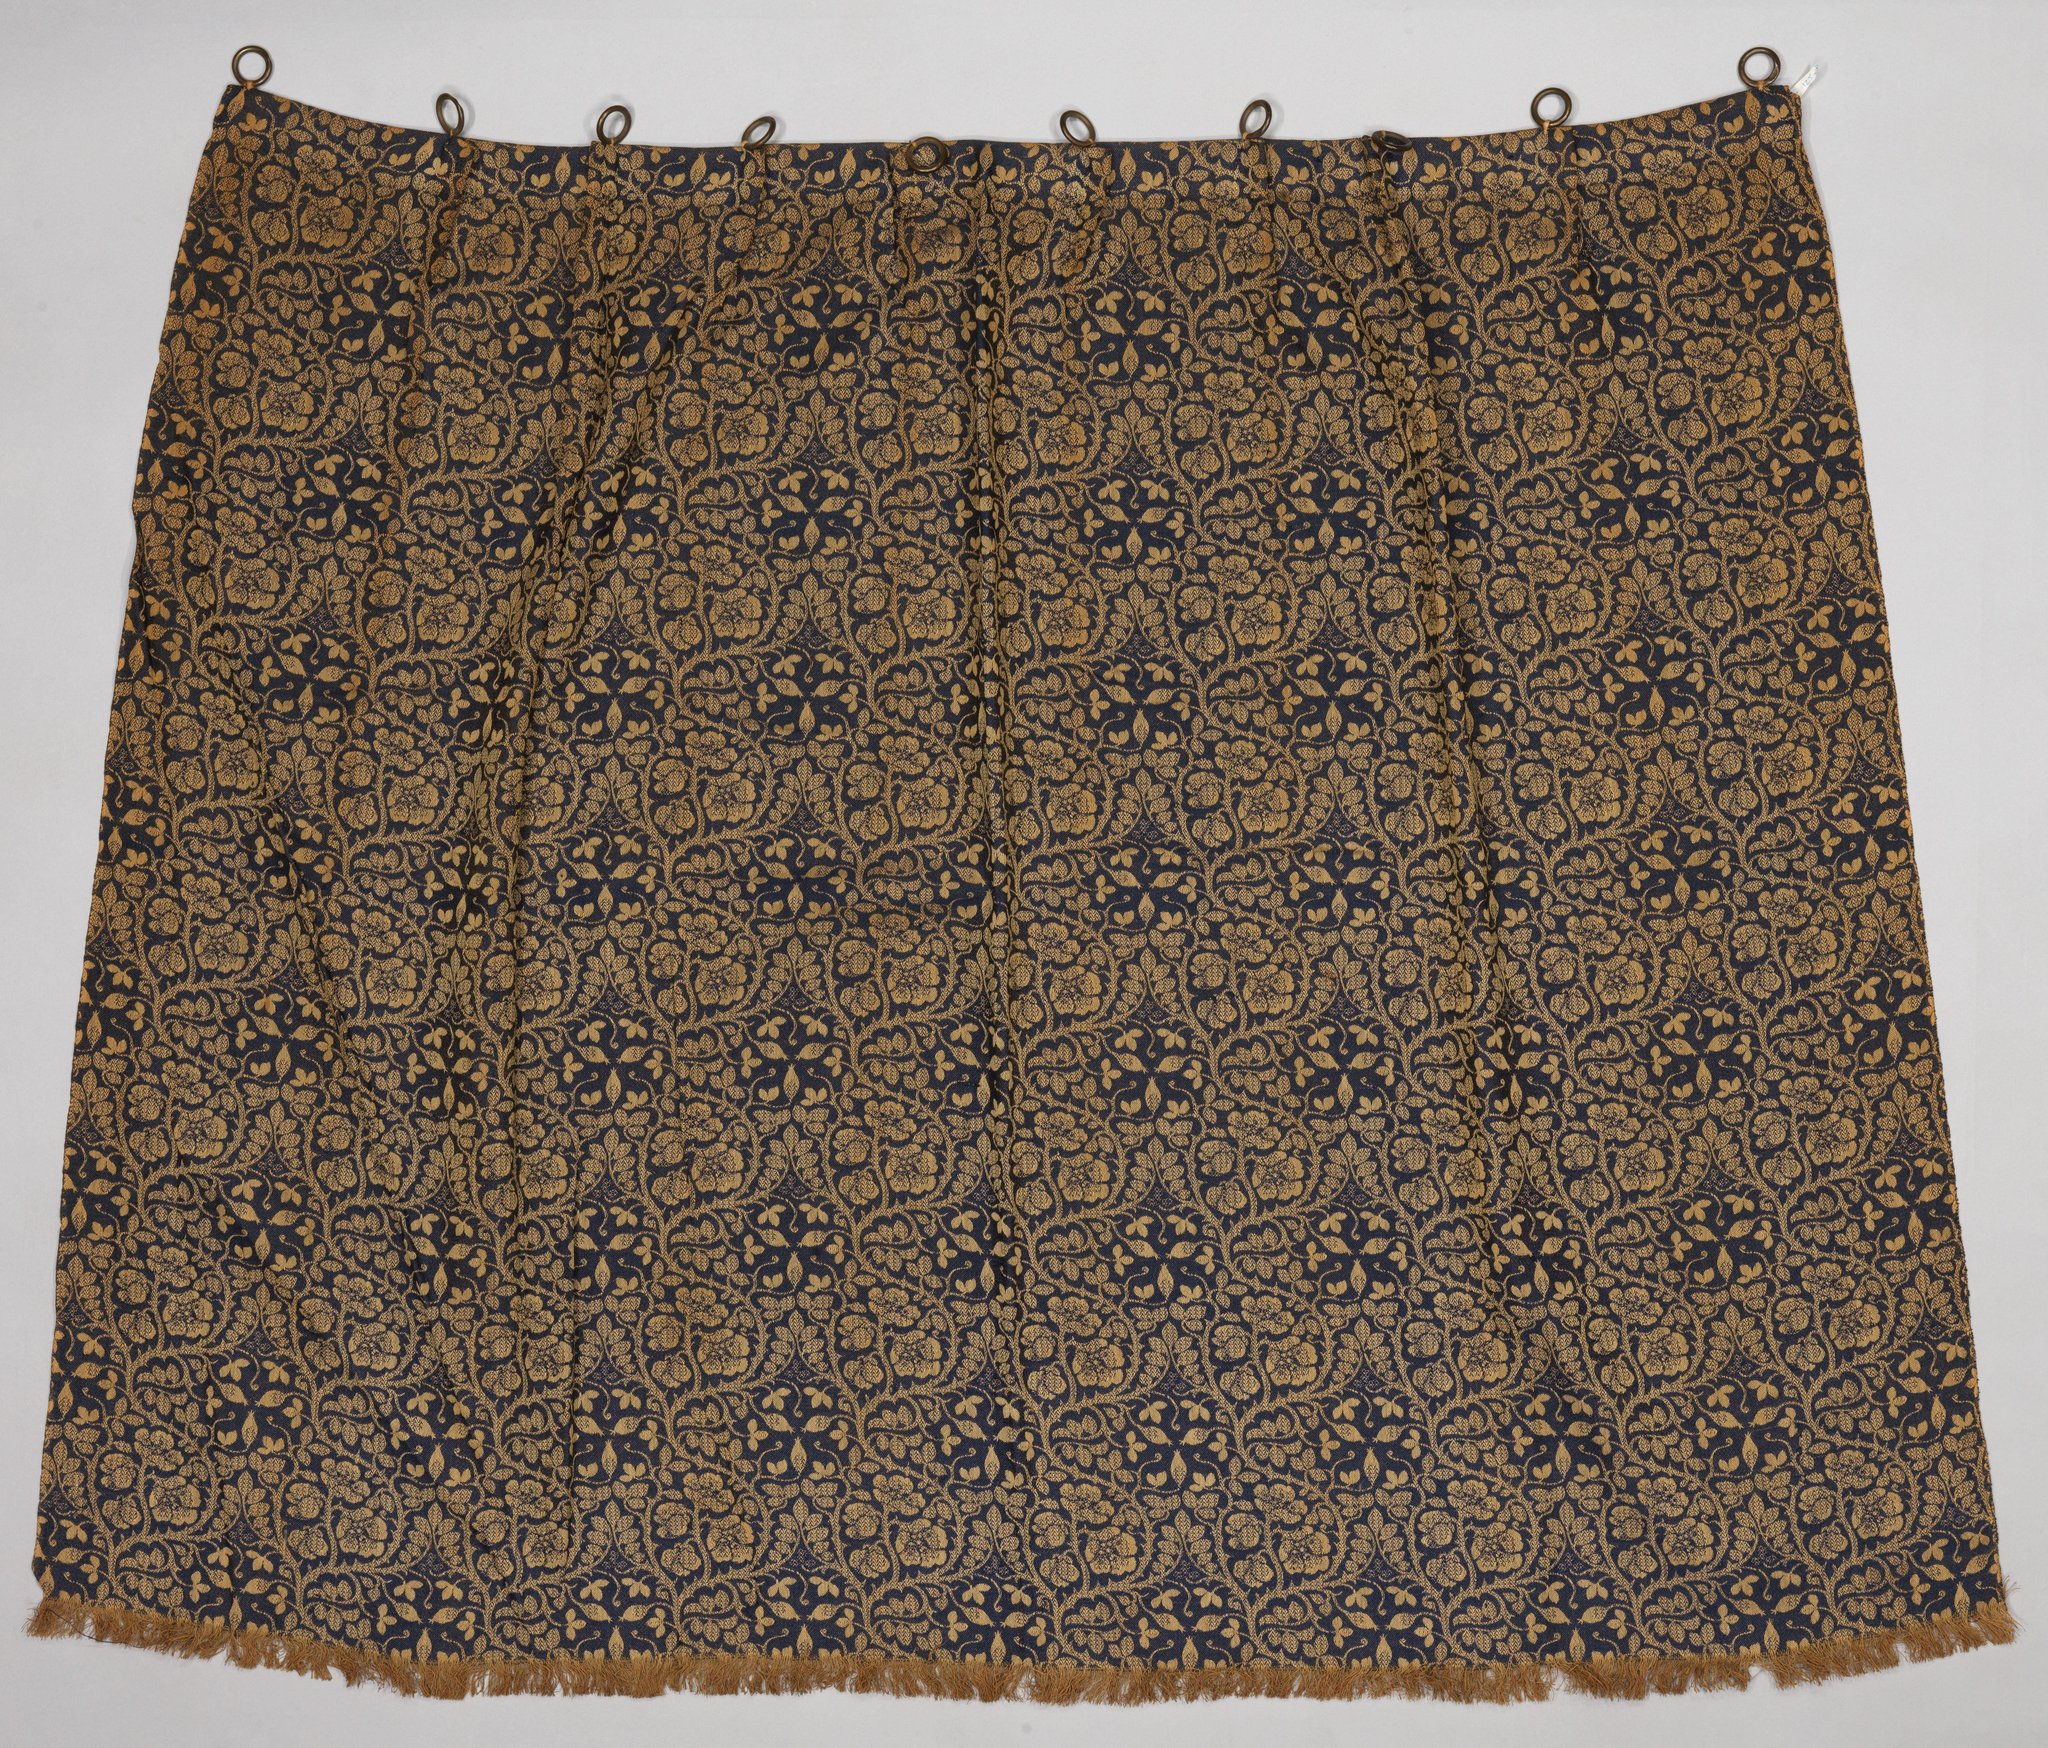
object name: curtain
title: Gordijn met patroon van rozen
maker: theo nieuwenhuis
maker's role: designer, draughtsman, print maker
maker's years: 1866-1951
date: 1900-1925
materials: cotton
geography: netherlands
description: Gordijn met patroon van rozen. Blauwe ketting op gele inslag.